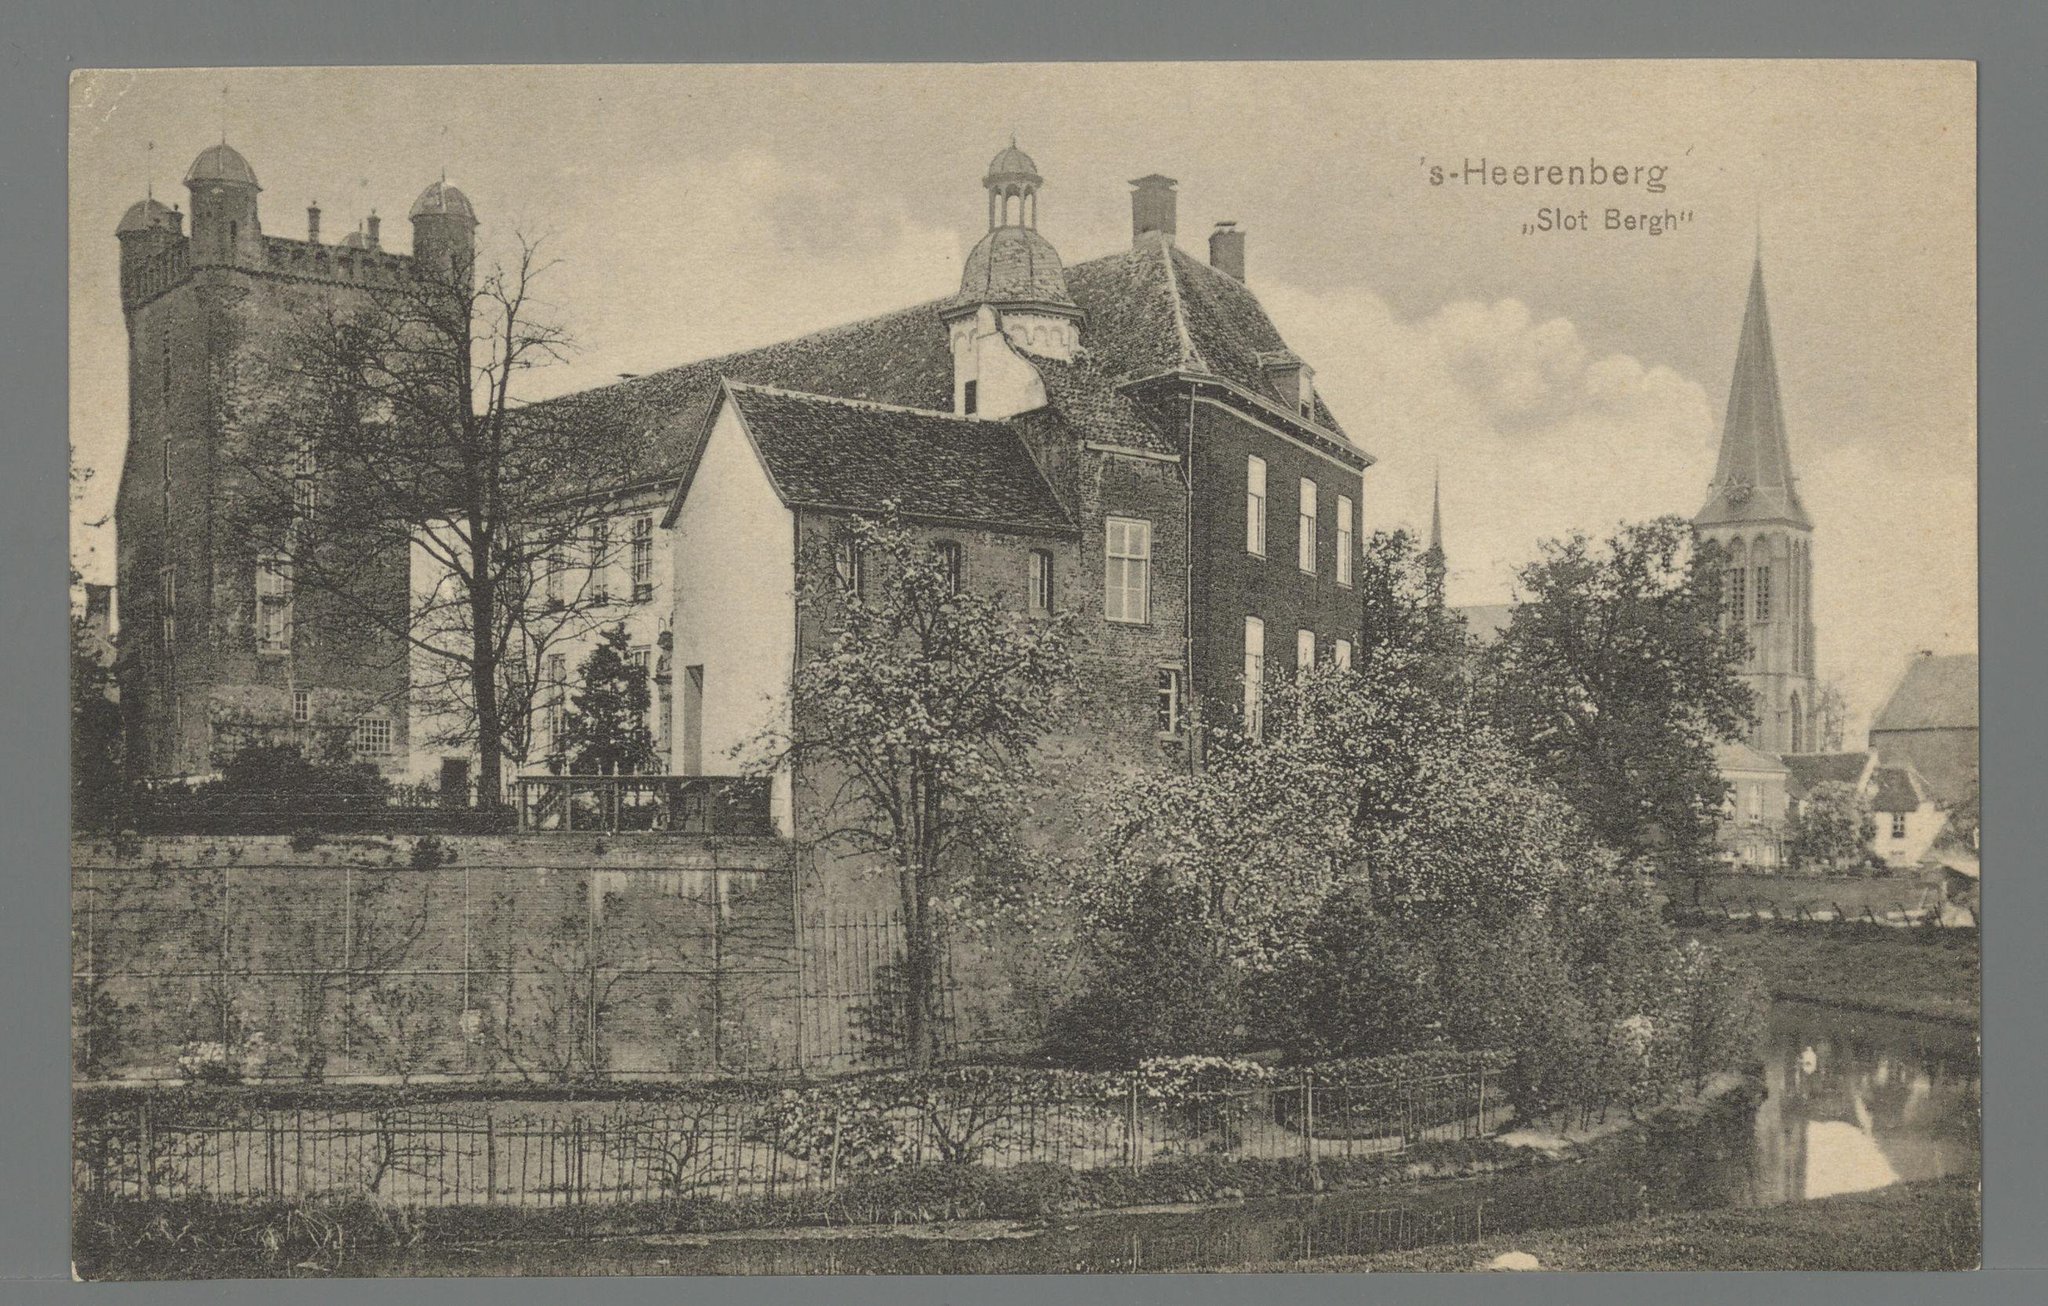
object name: photomechanical print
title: 's-Heerenberg "Slot Bergh"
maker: Anonymous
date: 1910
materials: cardboard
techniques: photograph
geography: s-heerenberg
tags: castle, canal, church (exterior)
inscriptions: date